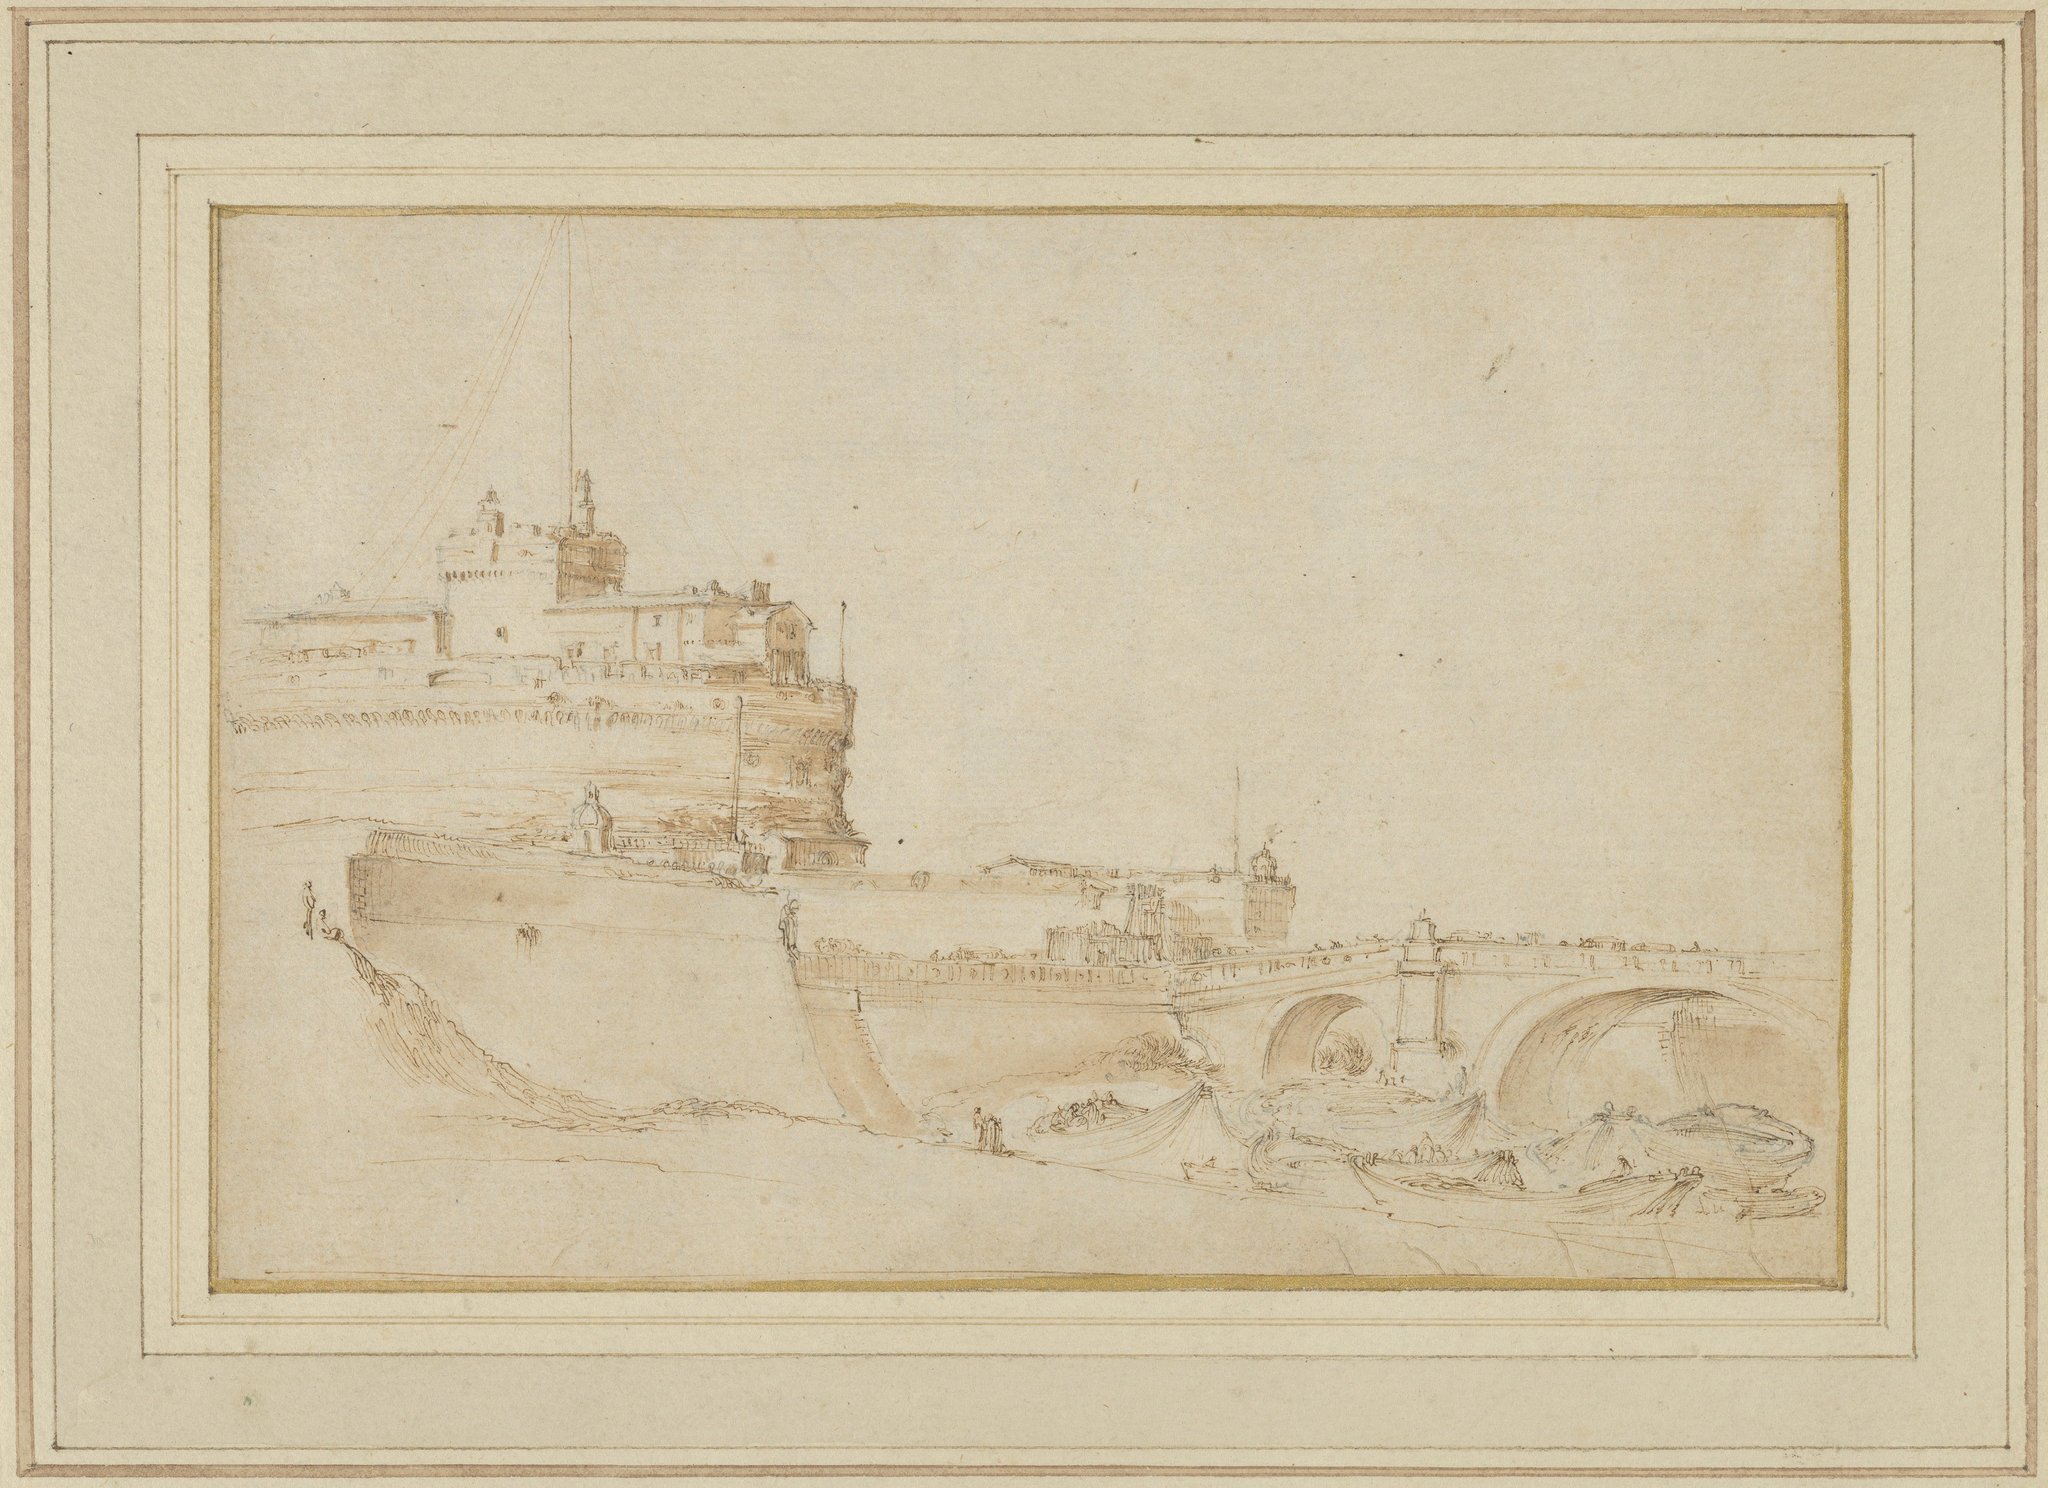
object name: drawing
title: Ponte and Castell Saint'Angelo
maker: stefano della bella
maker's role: artist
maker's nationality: italian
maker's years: 1610-1664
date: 1633-1664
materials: graphite, ink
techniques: wash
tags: ships